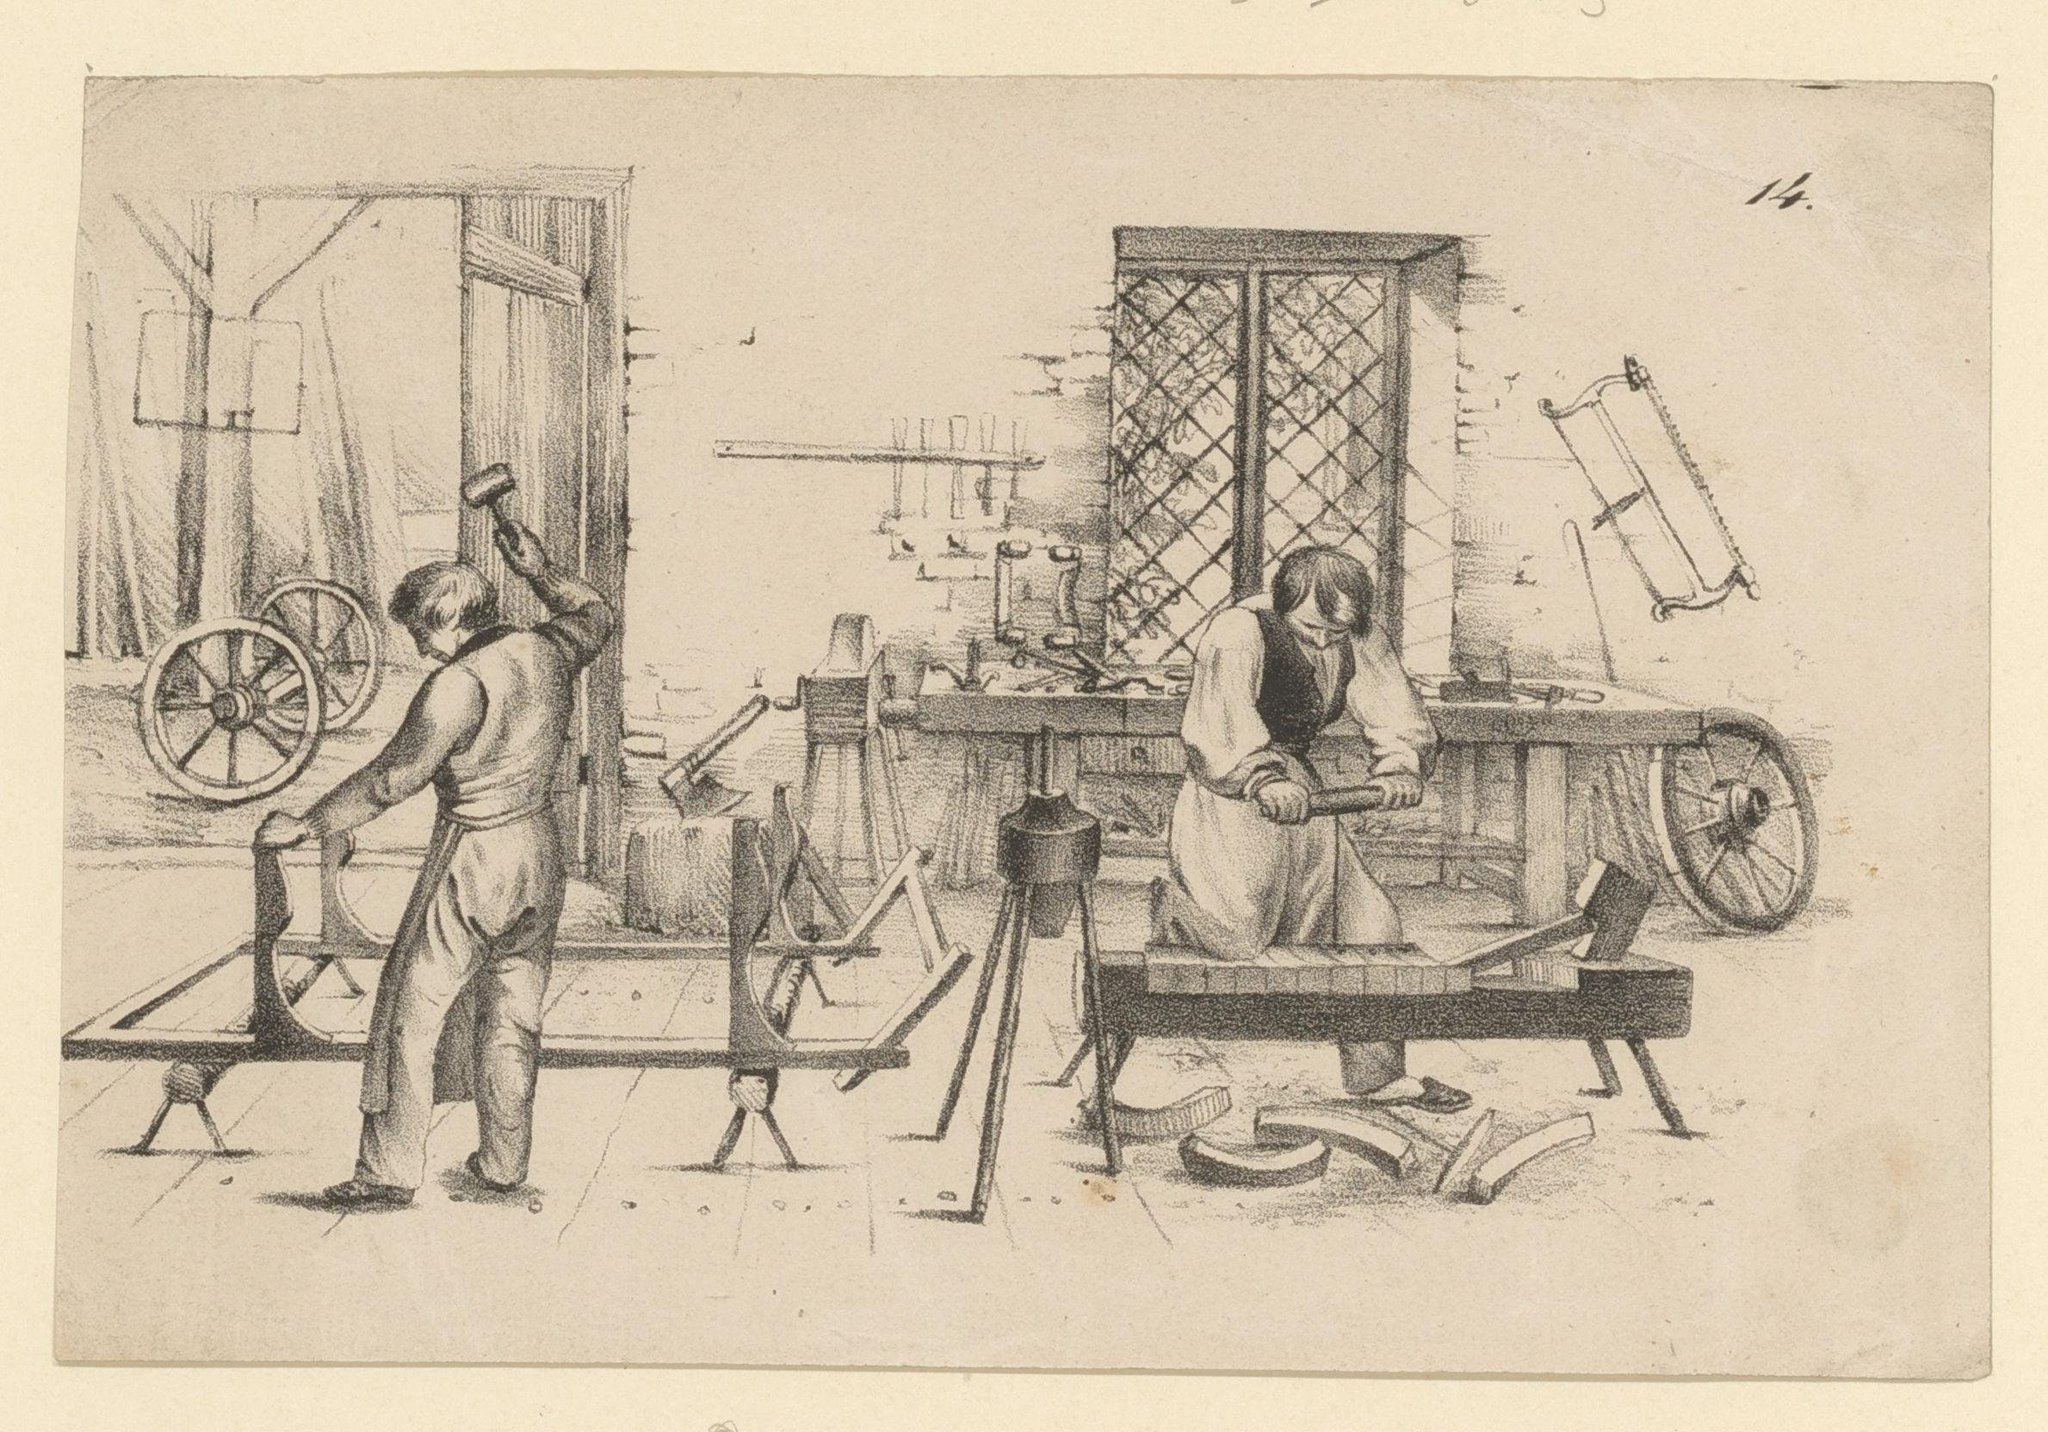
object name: print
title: Twee timmermannen in een werkplaats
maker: Anonymous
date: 1800-1899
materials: paper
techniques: lithograph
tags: carpenter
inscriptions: collector's mark: Lugt 1641, stamp, stamp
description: Twee timmermannen in een werkplaats, mogelijk maken zij een wagen of koets. Rechtsboven genummerd: 14. Onderwerpsrubrieken binnen de Atlas Zeden en Gewoonten: Handel, Nijverheid en verkeer, Beroep en bedrijf, Mannelijk, Bewerkers van het hout.